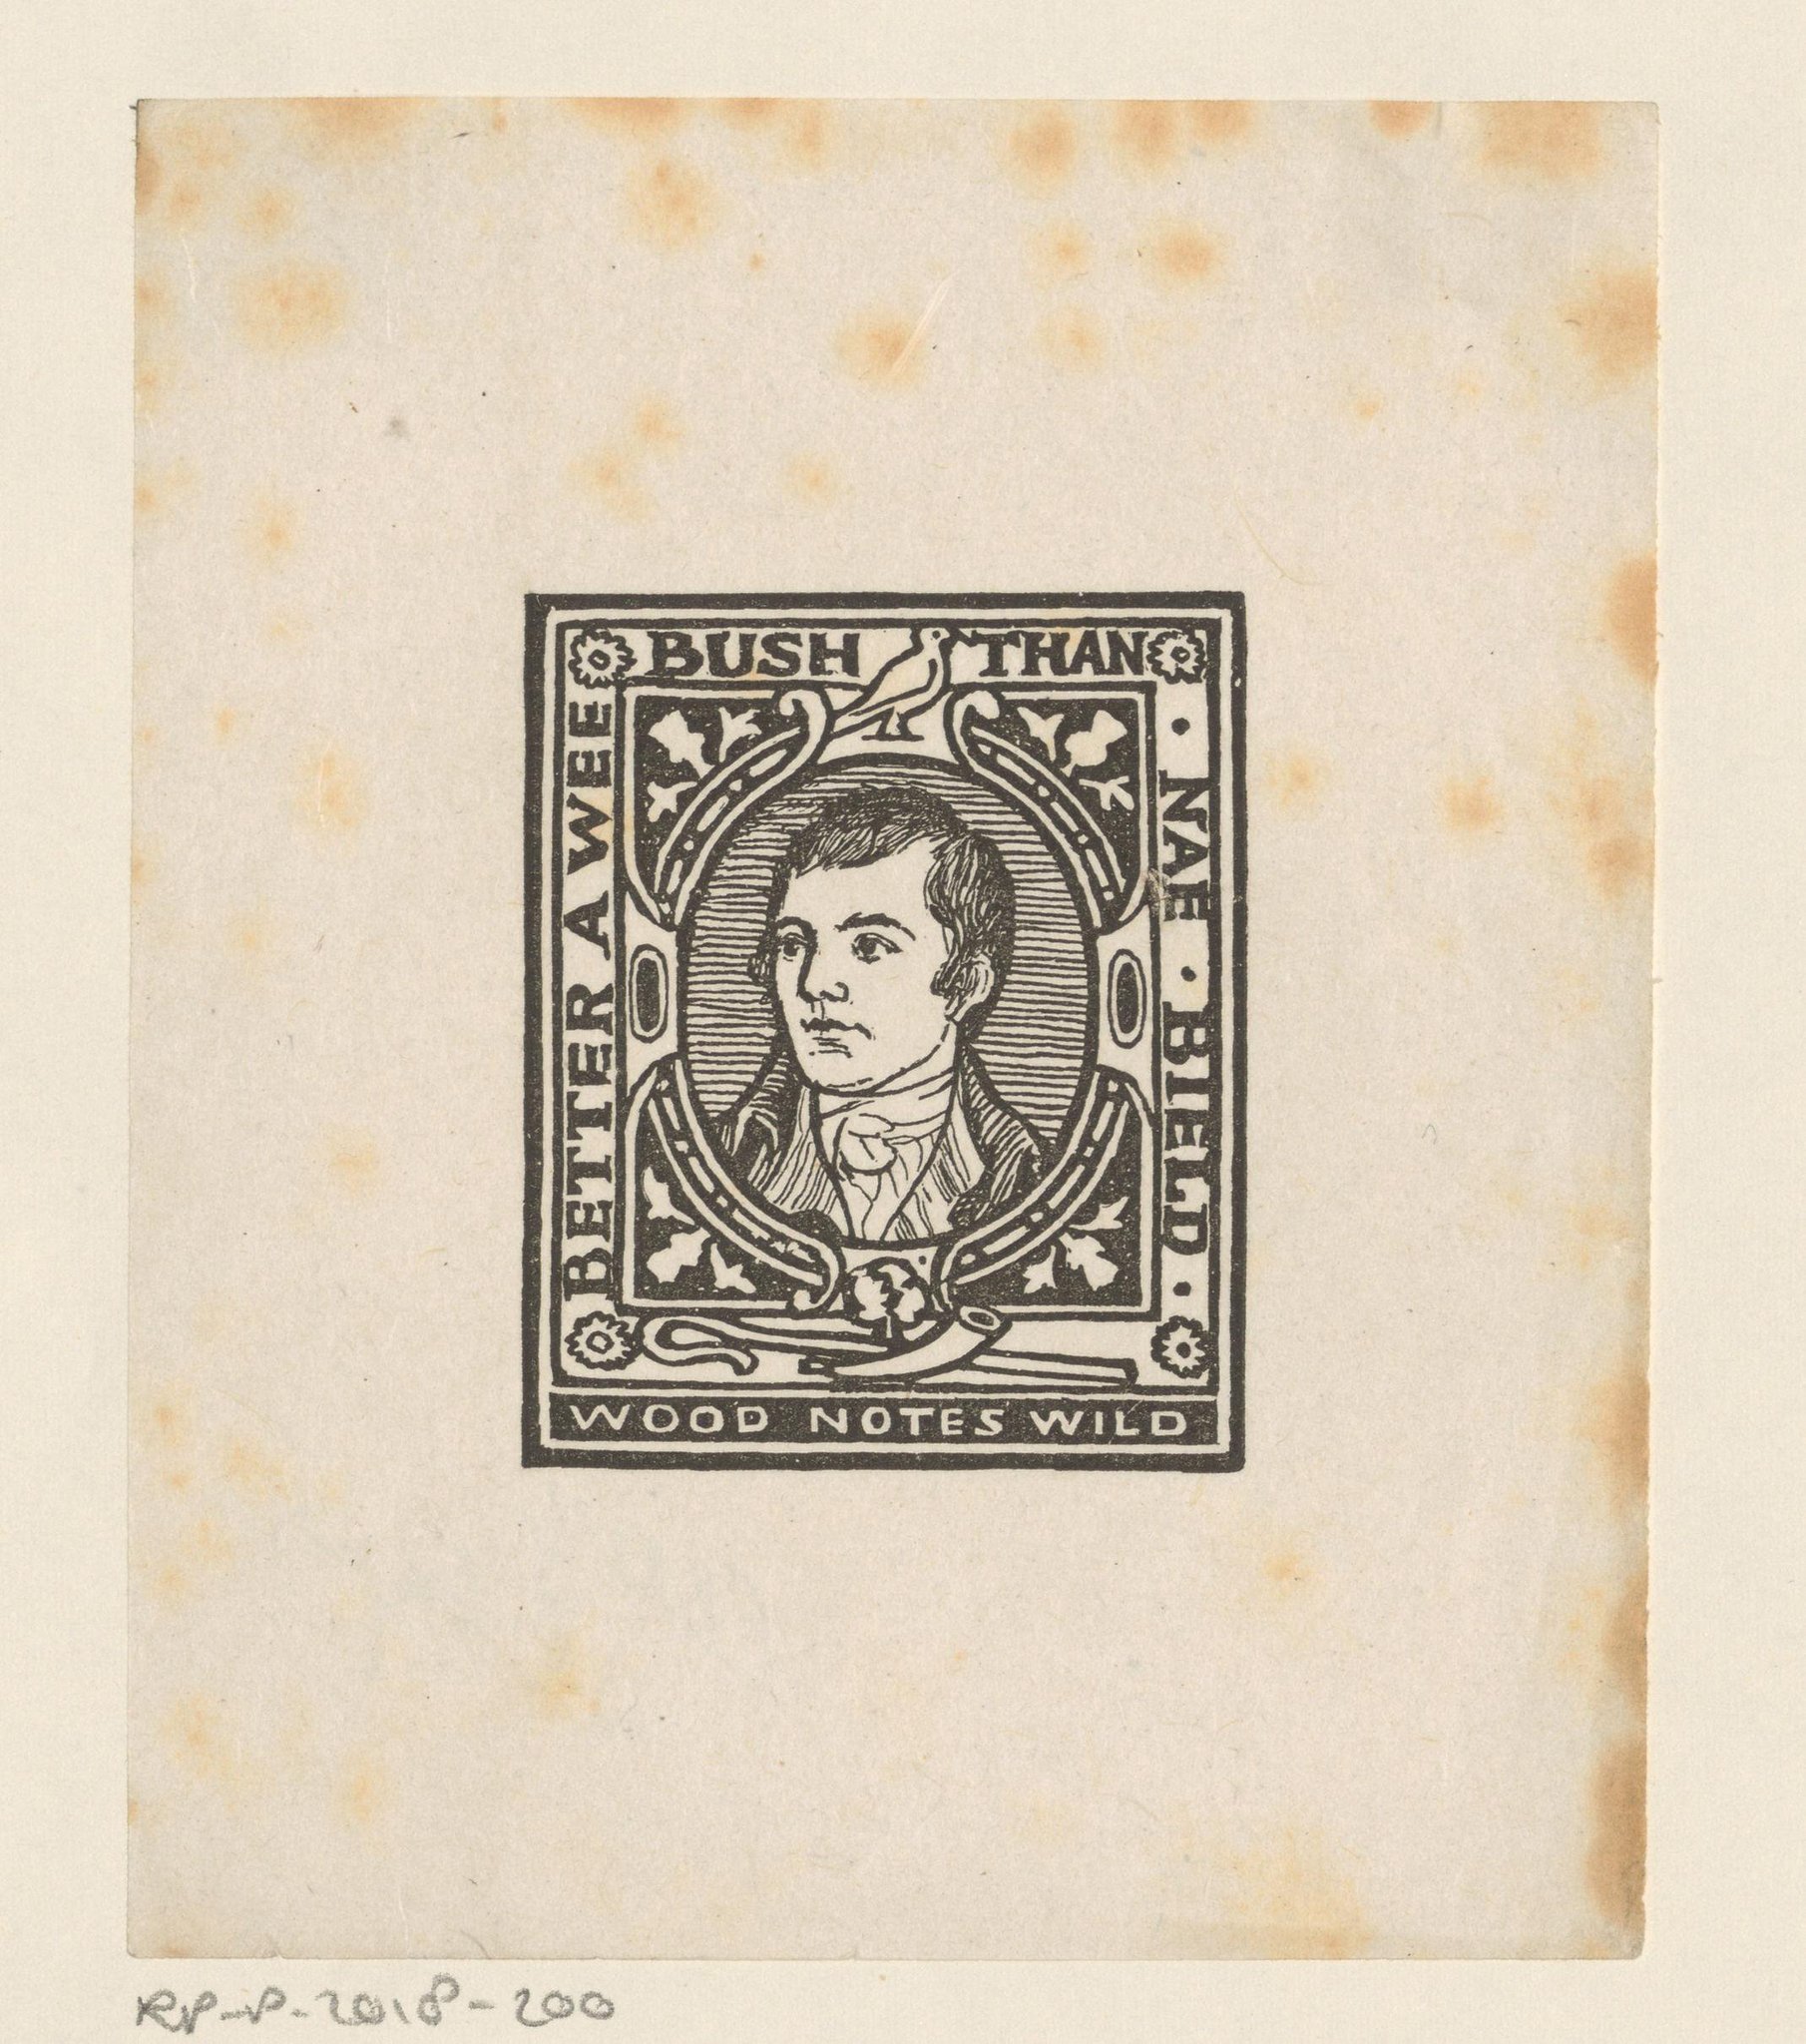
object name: bookplate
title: Better a wee bush than nae bield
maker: Anonymous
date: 1876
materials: paper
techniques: printing block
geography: england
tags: head (human), birds, historical persons